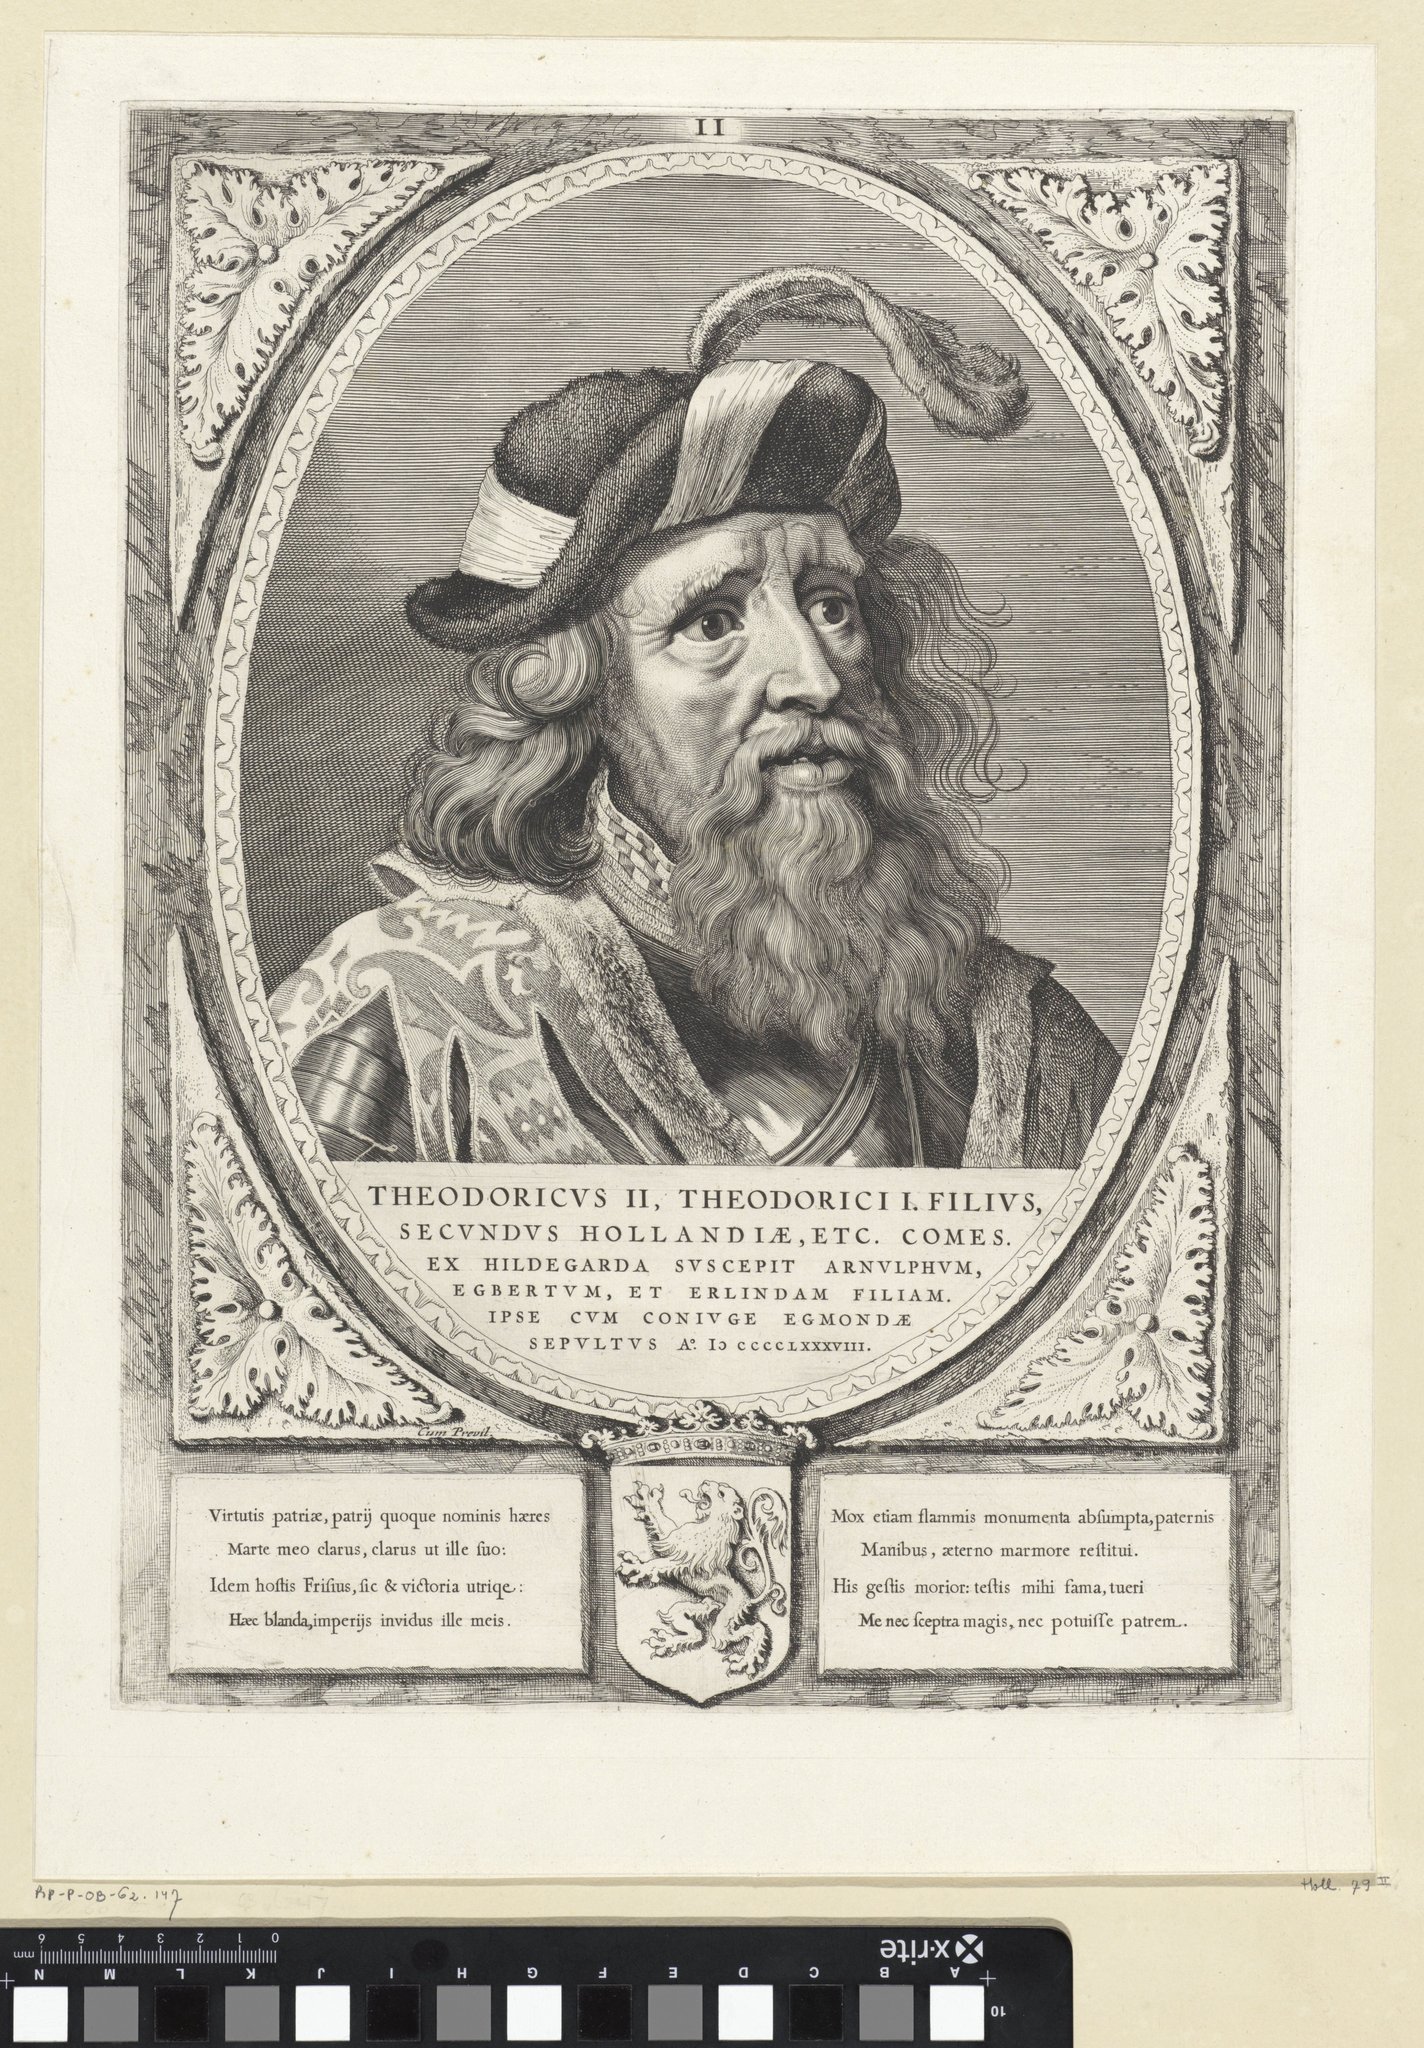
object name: print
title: Portret van Dirk II, graaf van Holland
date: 1650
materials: paper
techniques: engraving, etching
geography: haarlem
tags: head-gear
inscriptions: collector's mark: Lugt 12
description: Proefdruk van de tweede prent uit de serie 'Graven en gravinnen van Holland, Zeeland en West-Friesland', bestaande uit 38 prenten.